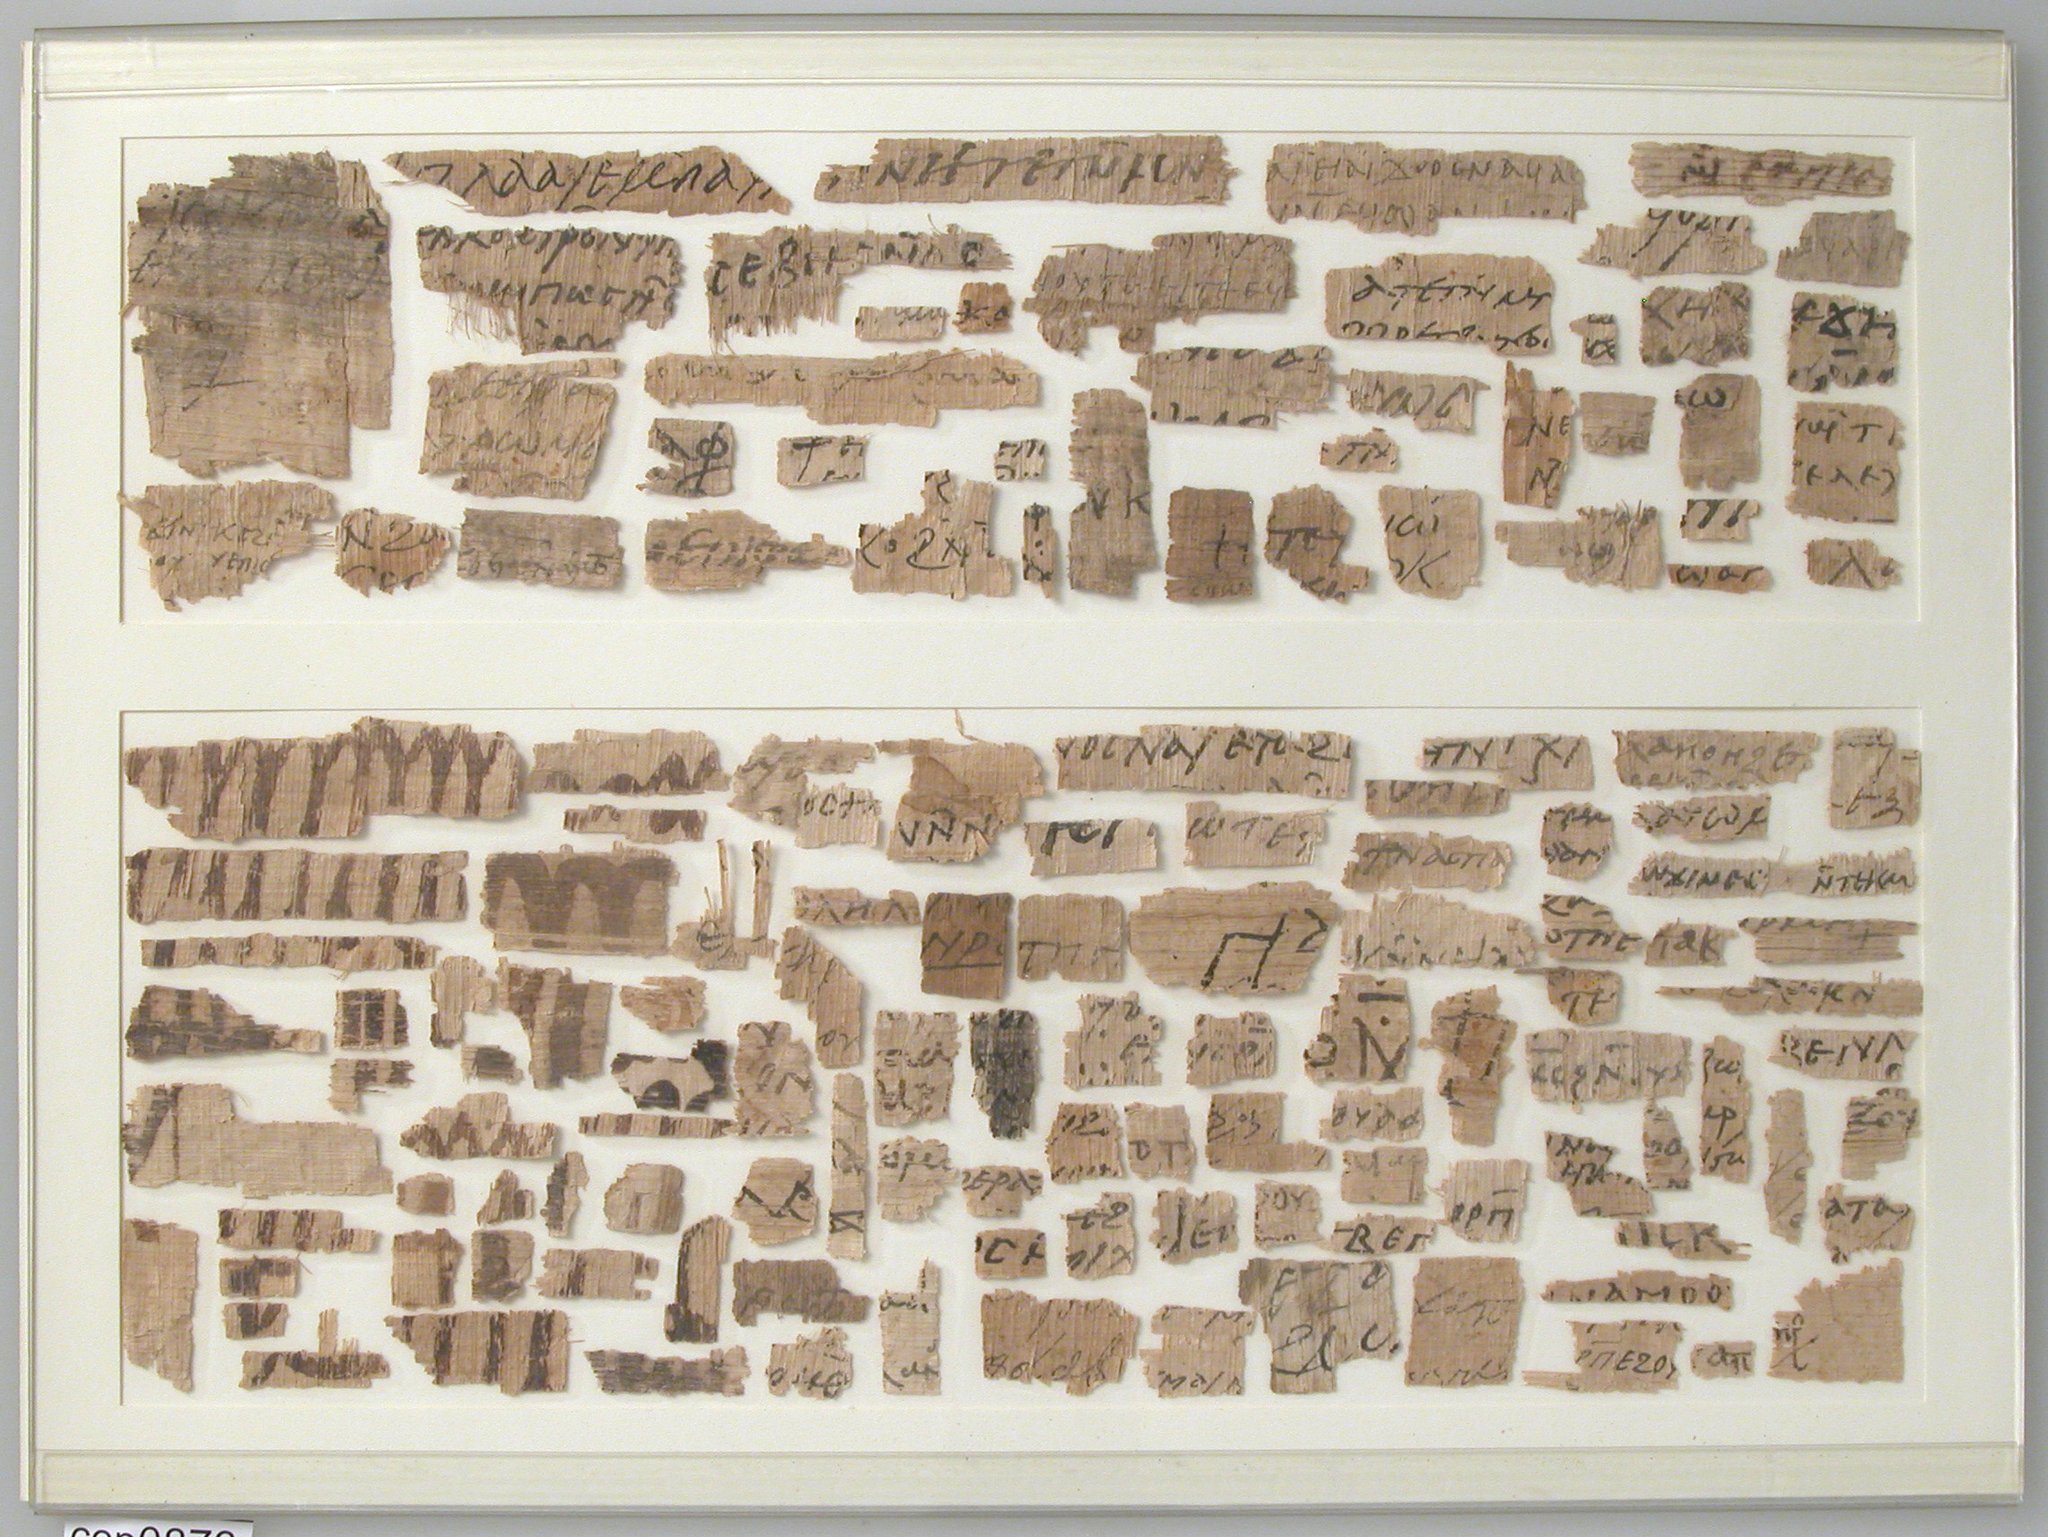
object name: fragment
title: Papyri Fragments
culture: coptic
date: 601-700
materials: ink, papyrus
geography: egypt